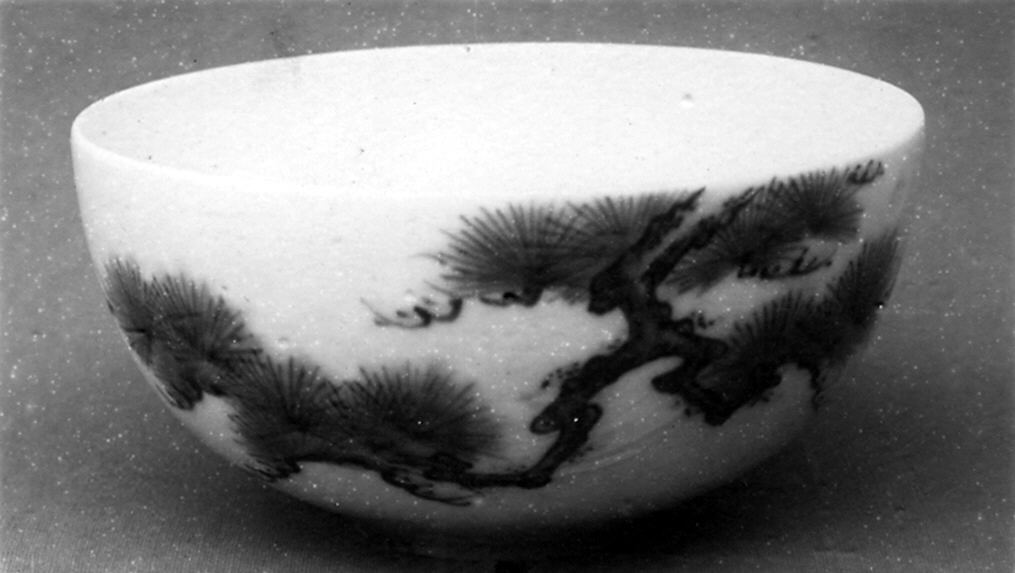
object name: bowl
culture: japanese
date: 1820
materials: glaze, porcelain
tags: trees